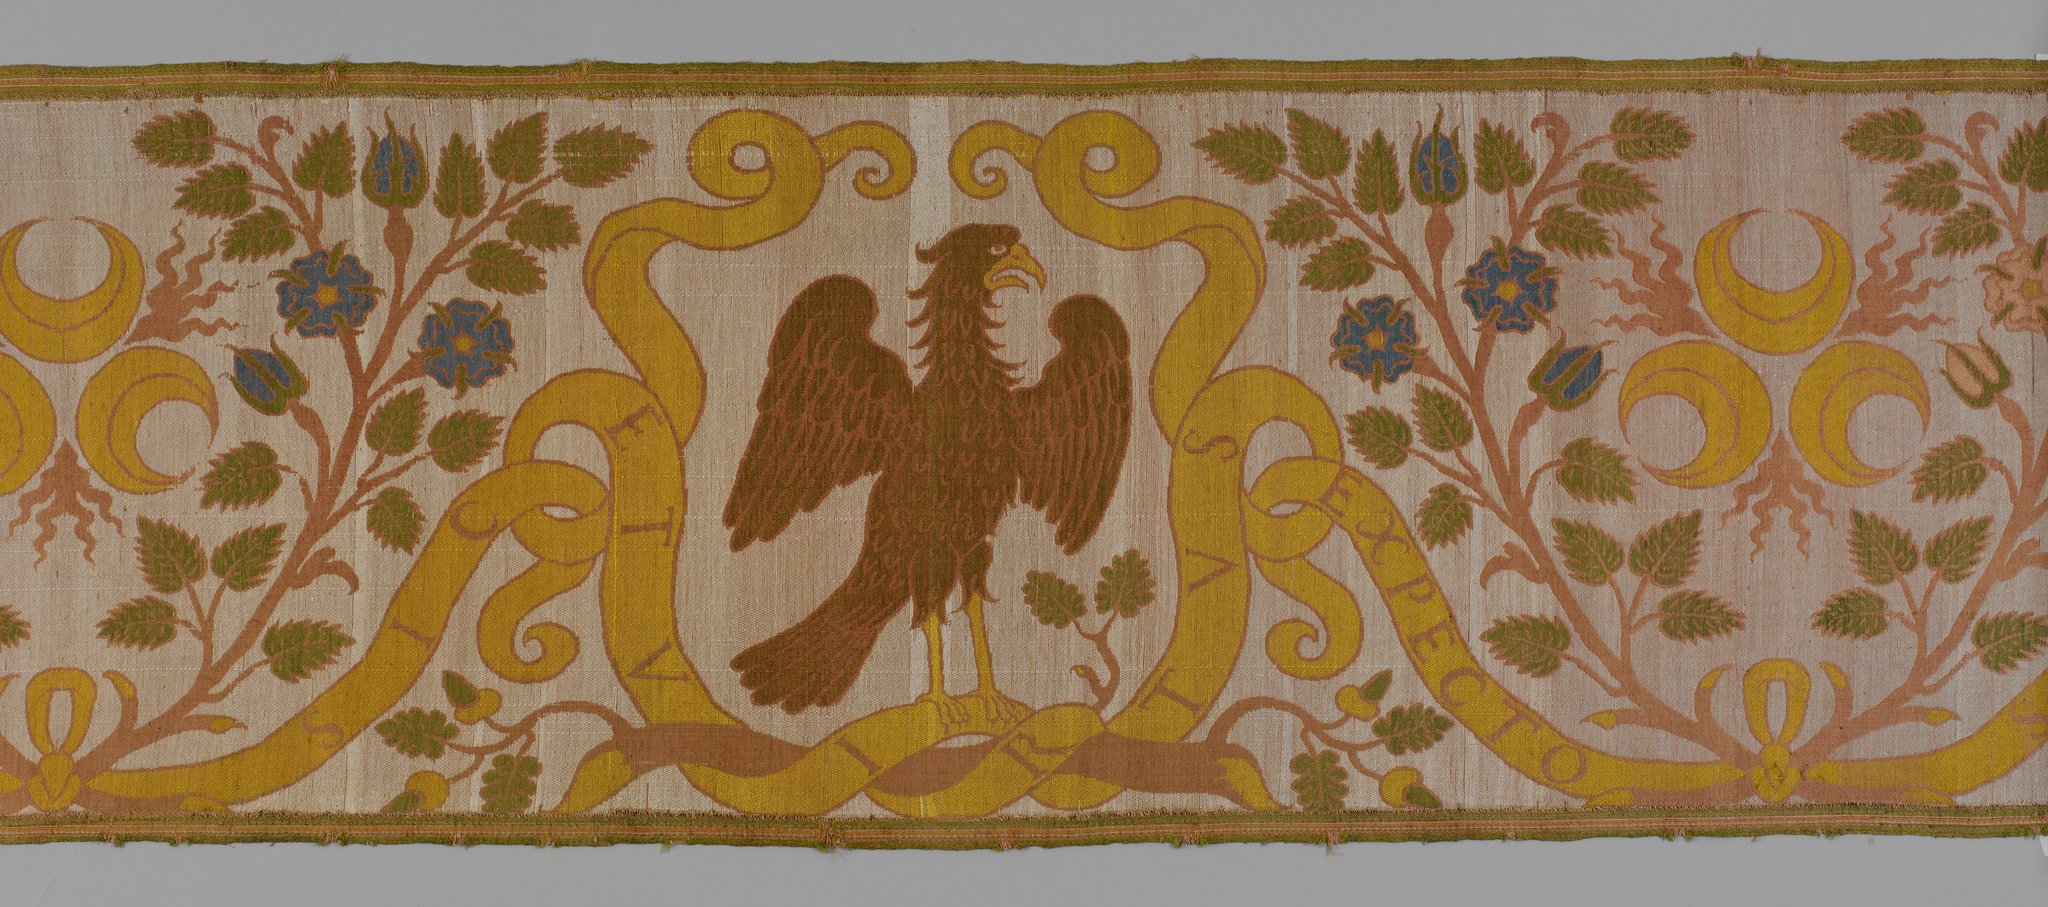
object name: border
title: Border with Strozzi emblems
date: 1501-1700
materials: linen, silk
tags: eagles